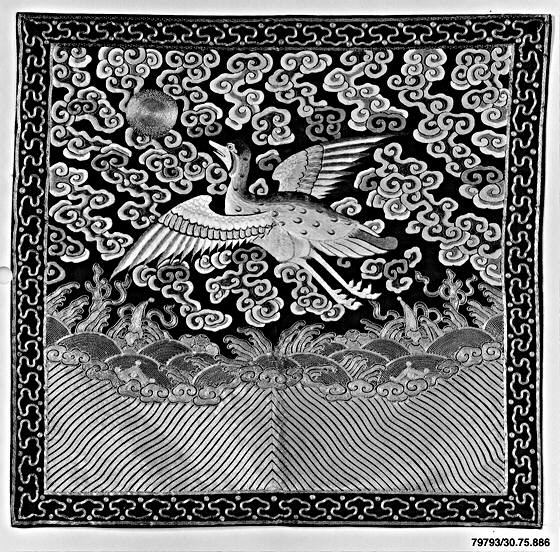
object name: rank badge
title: Rank Badge with Wild Goose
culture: chinese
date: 1767-1833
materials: metal thread, silk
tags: geese